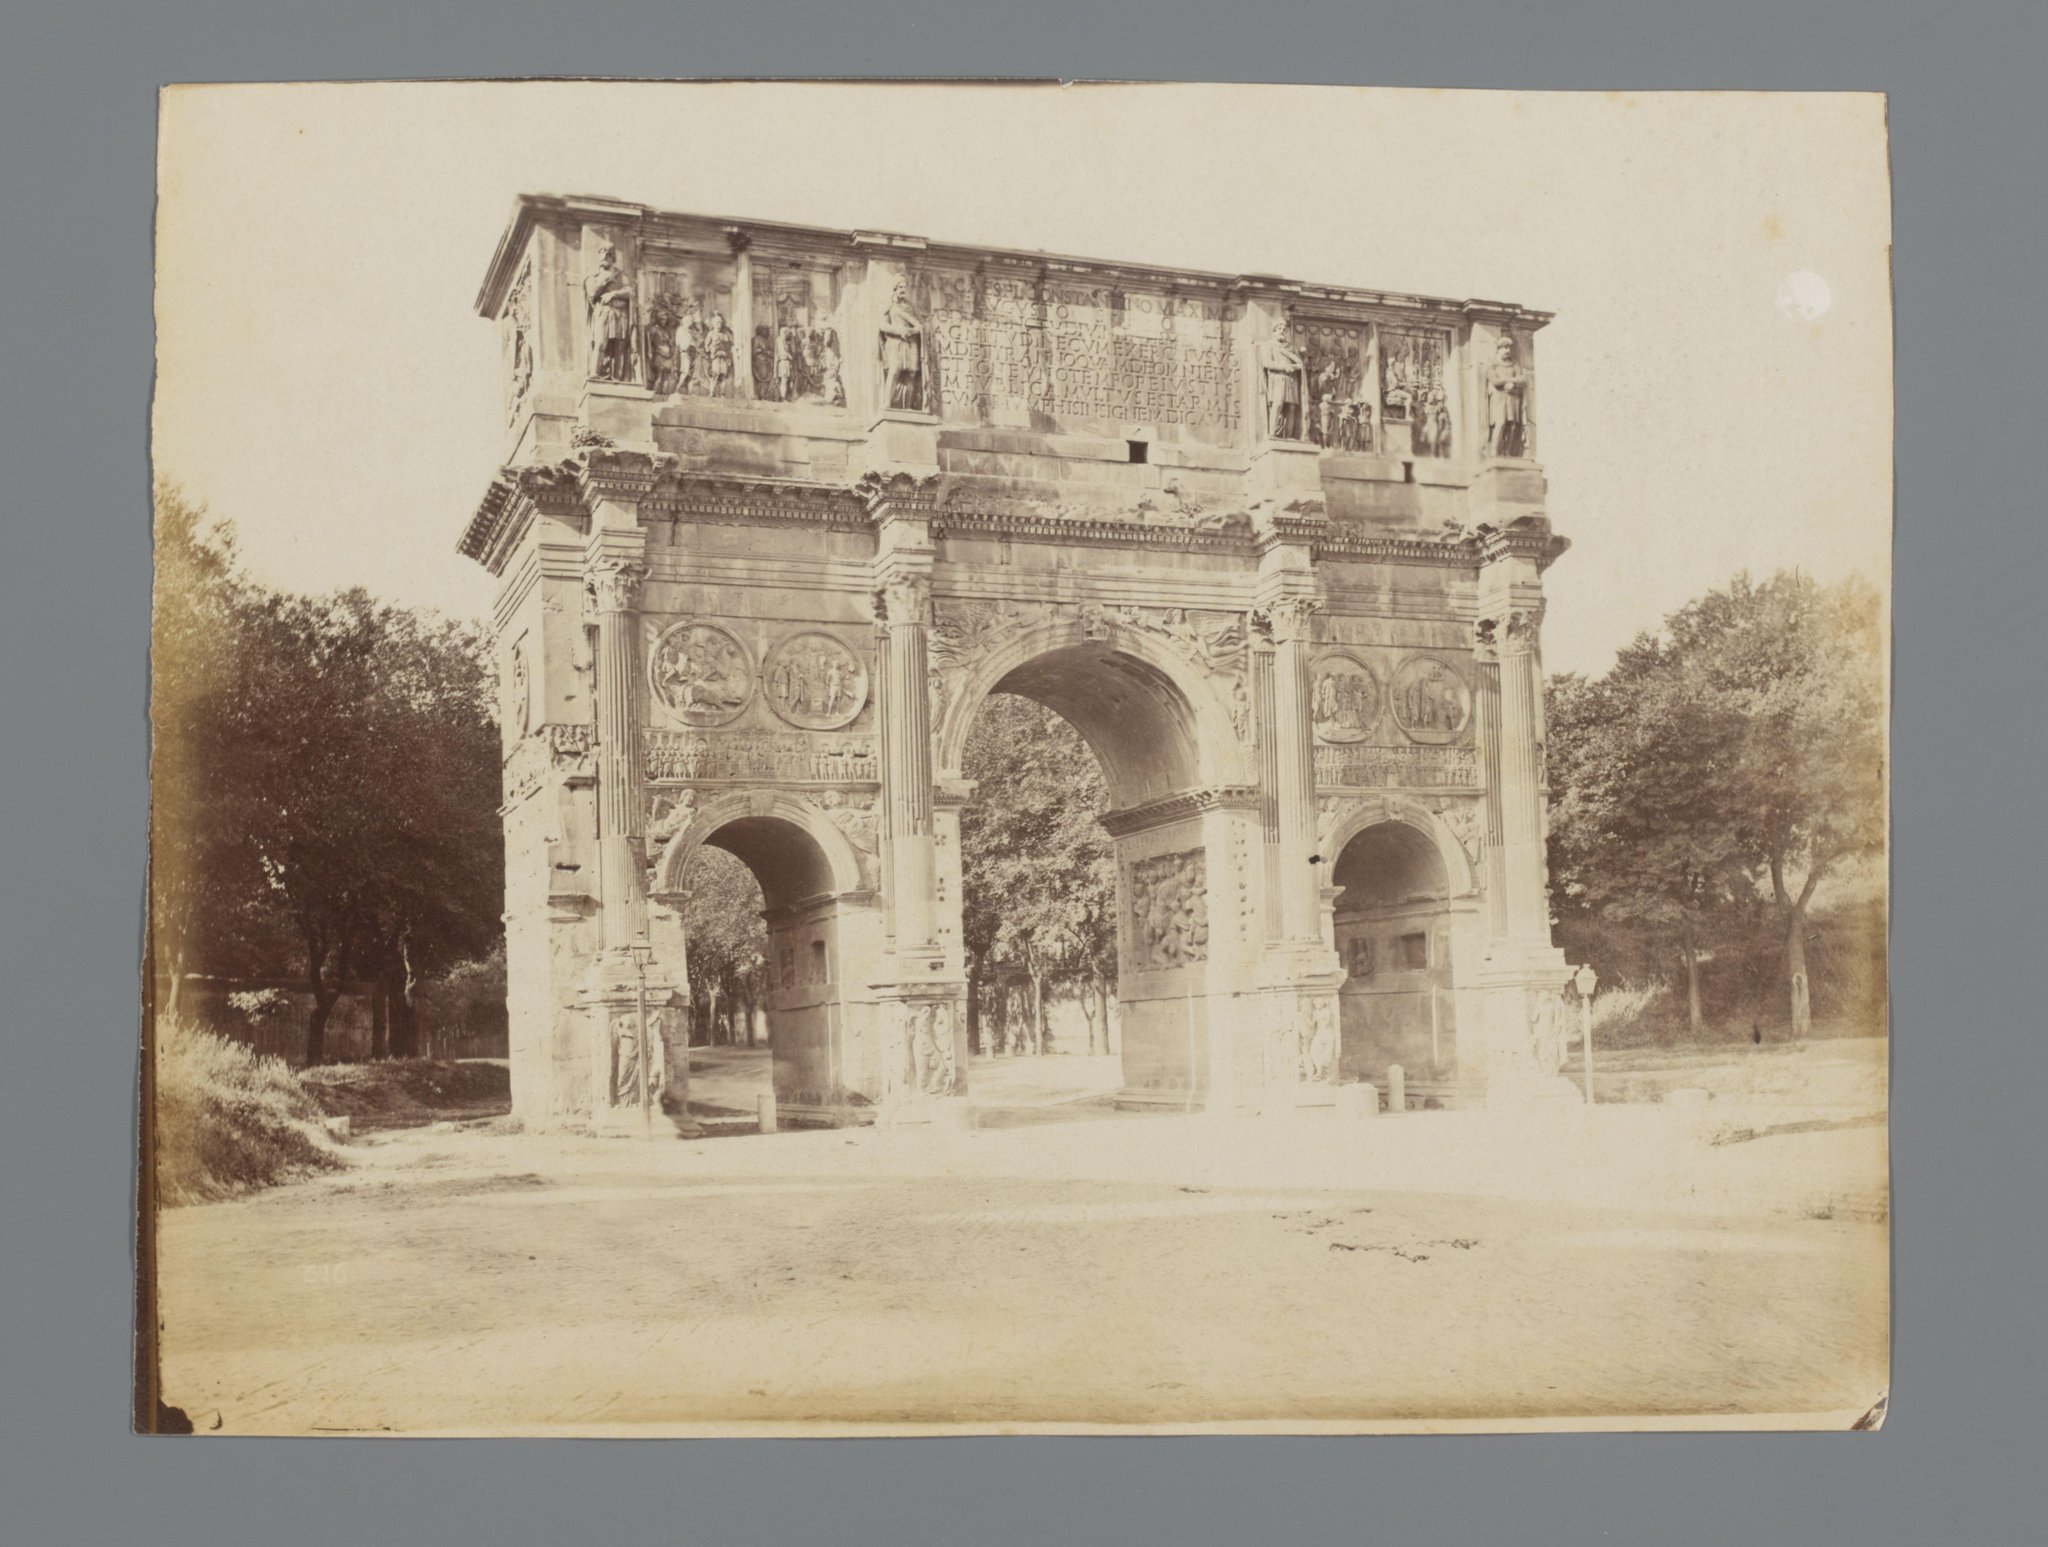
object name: photograph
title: Boog van Constantijn in Rome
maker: Anonymous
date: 1851-1900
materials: paper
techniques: albumen print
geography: rome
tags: triumphal arch, arch of constantine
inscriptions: collector's mark: ‘VOSMAER’, inscription: ‘[onleesbaar]’